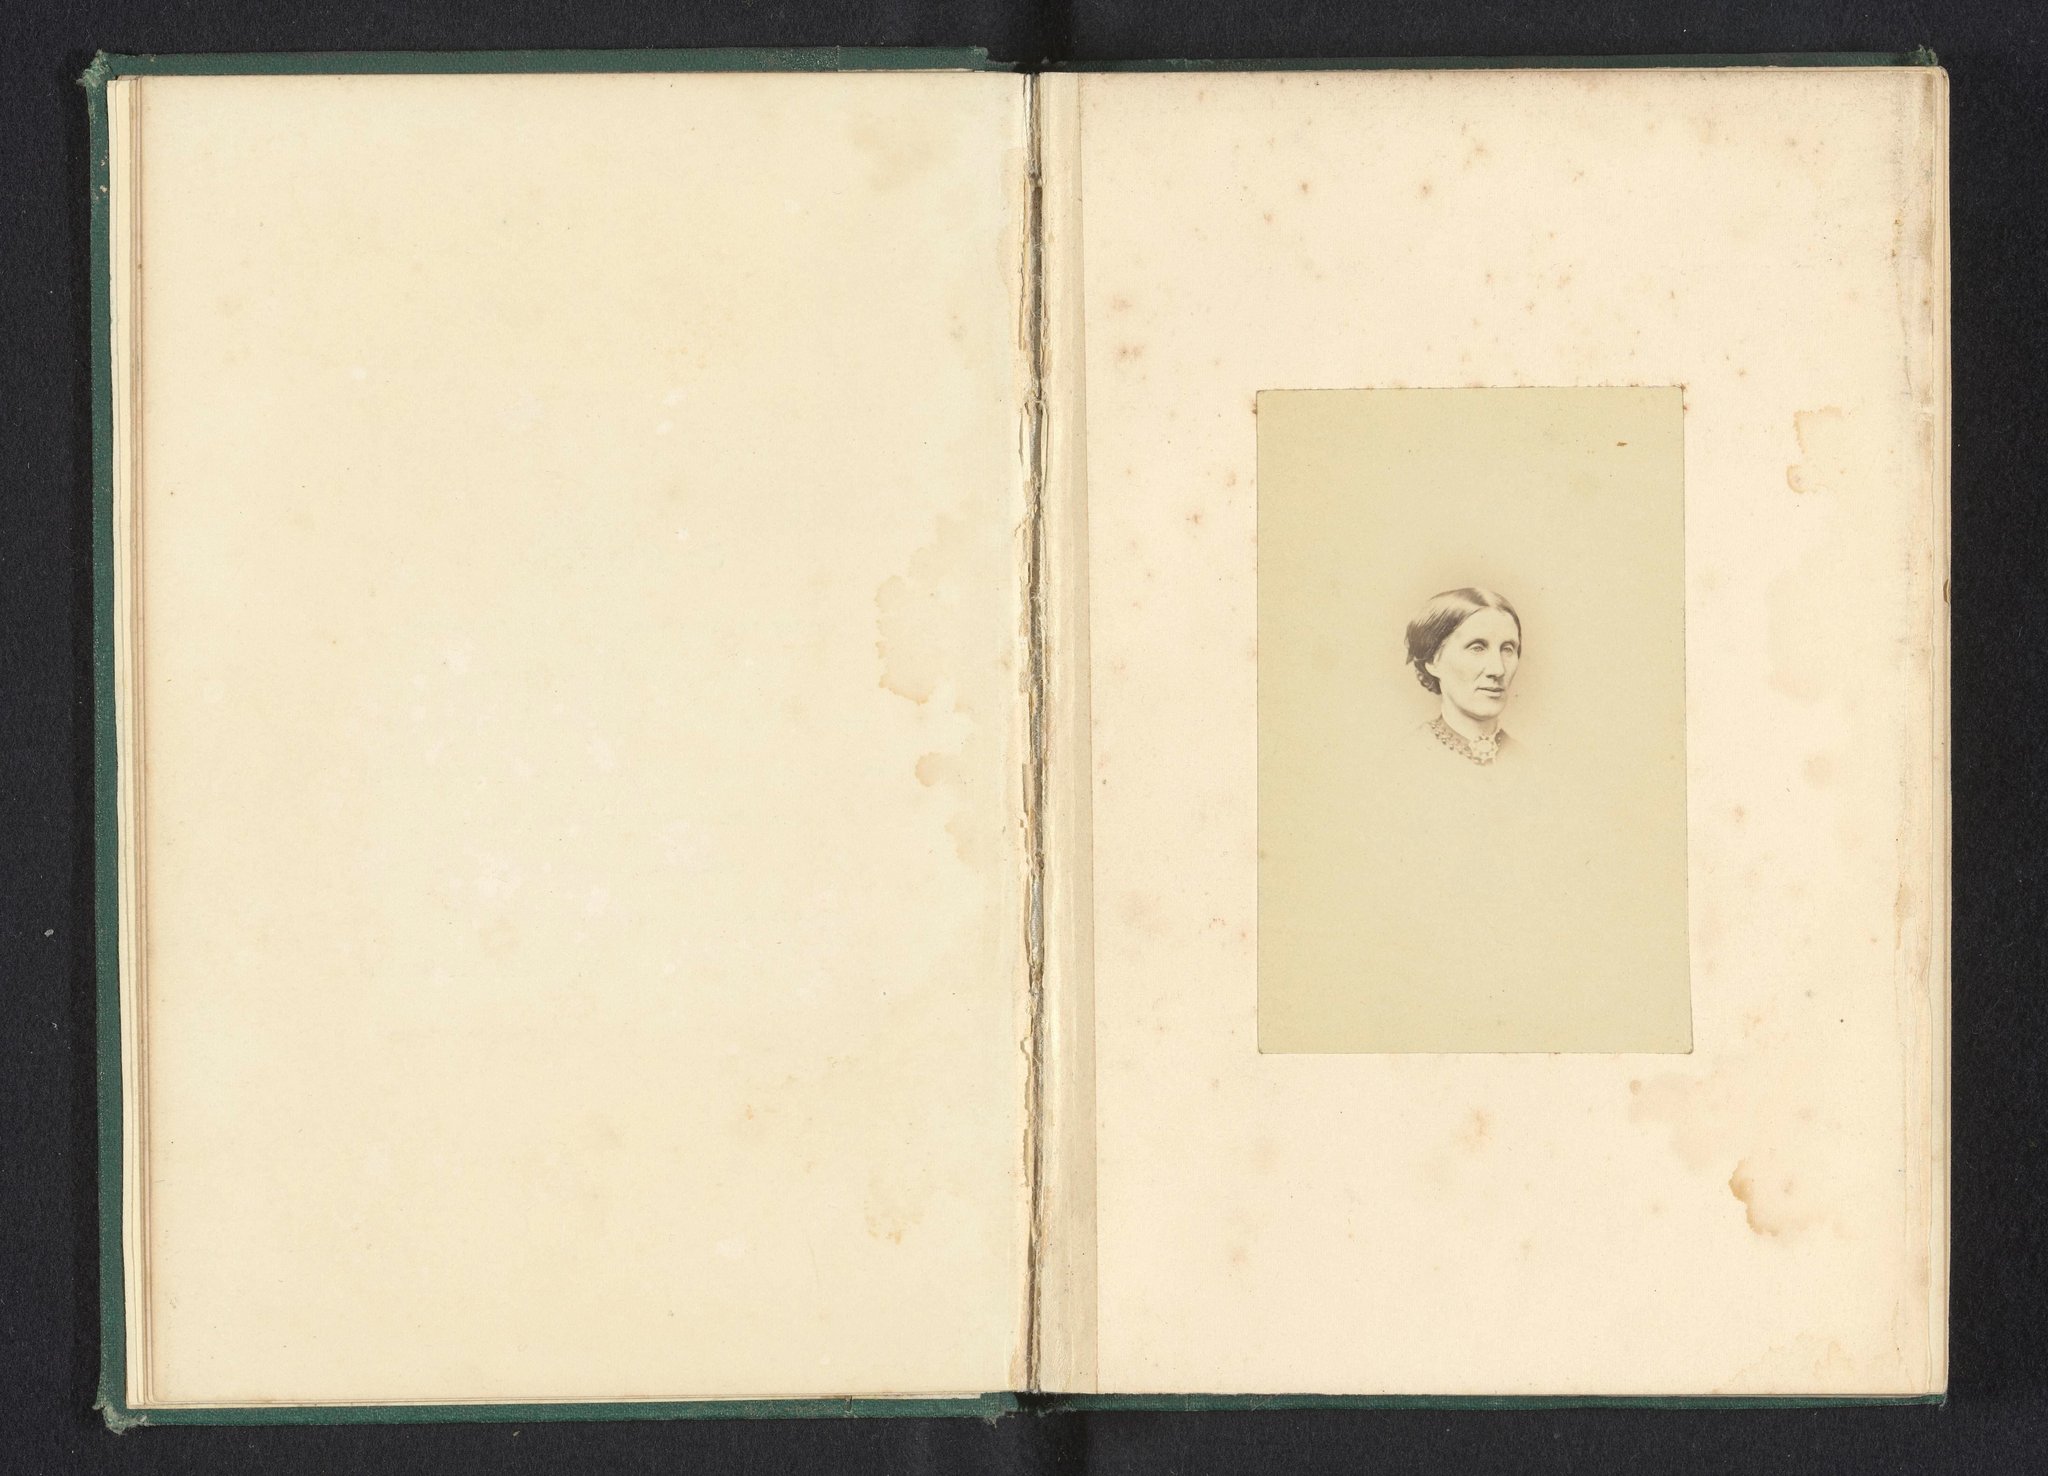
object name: page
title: Portret van Fanny Edith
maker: Anonymous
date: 1863-1868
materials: photographic support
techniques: albumen print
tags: historical persons - bb - woman